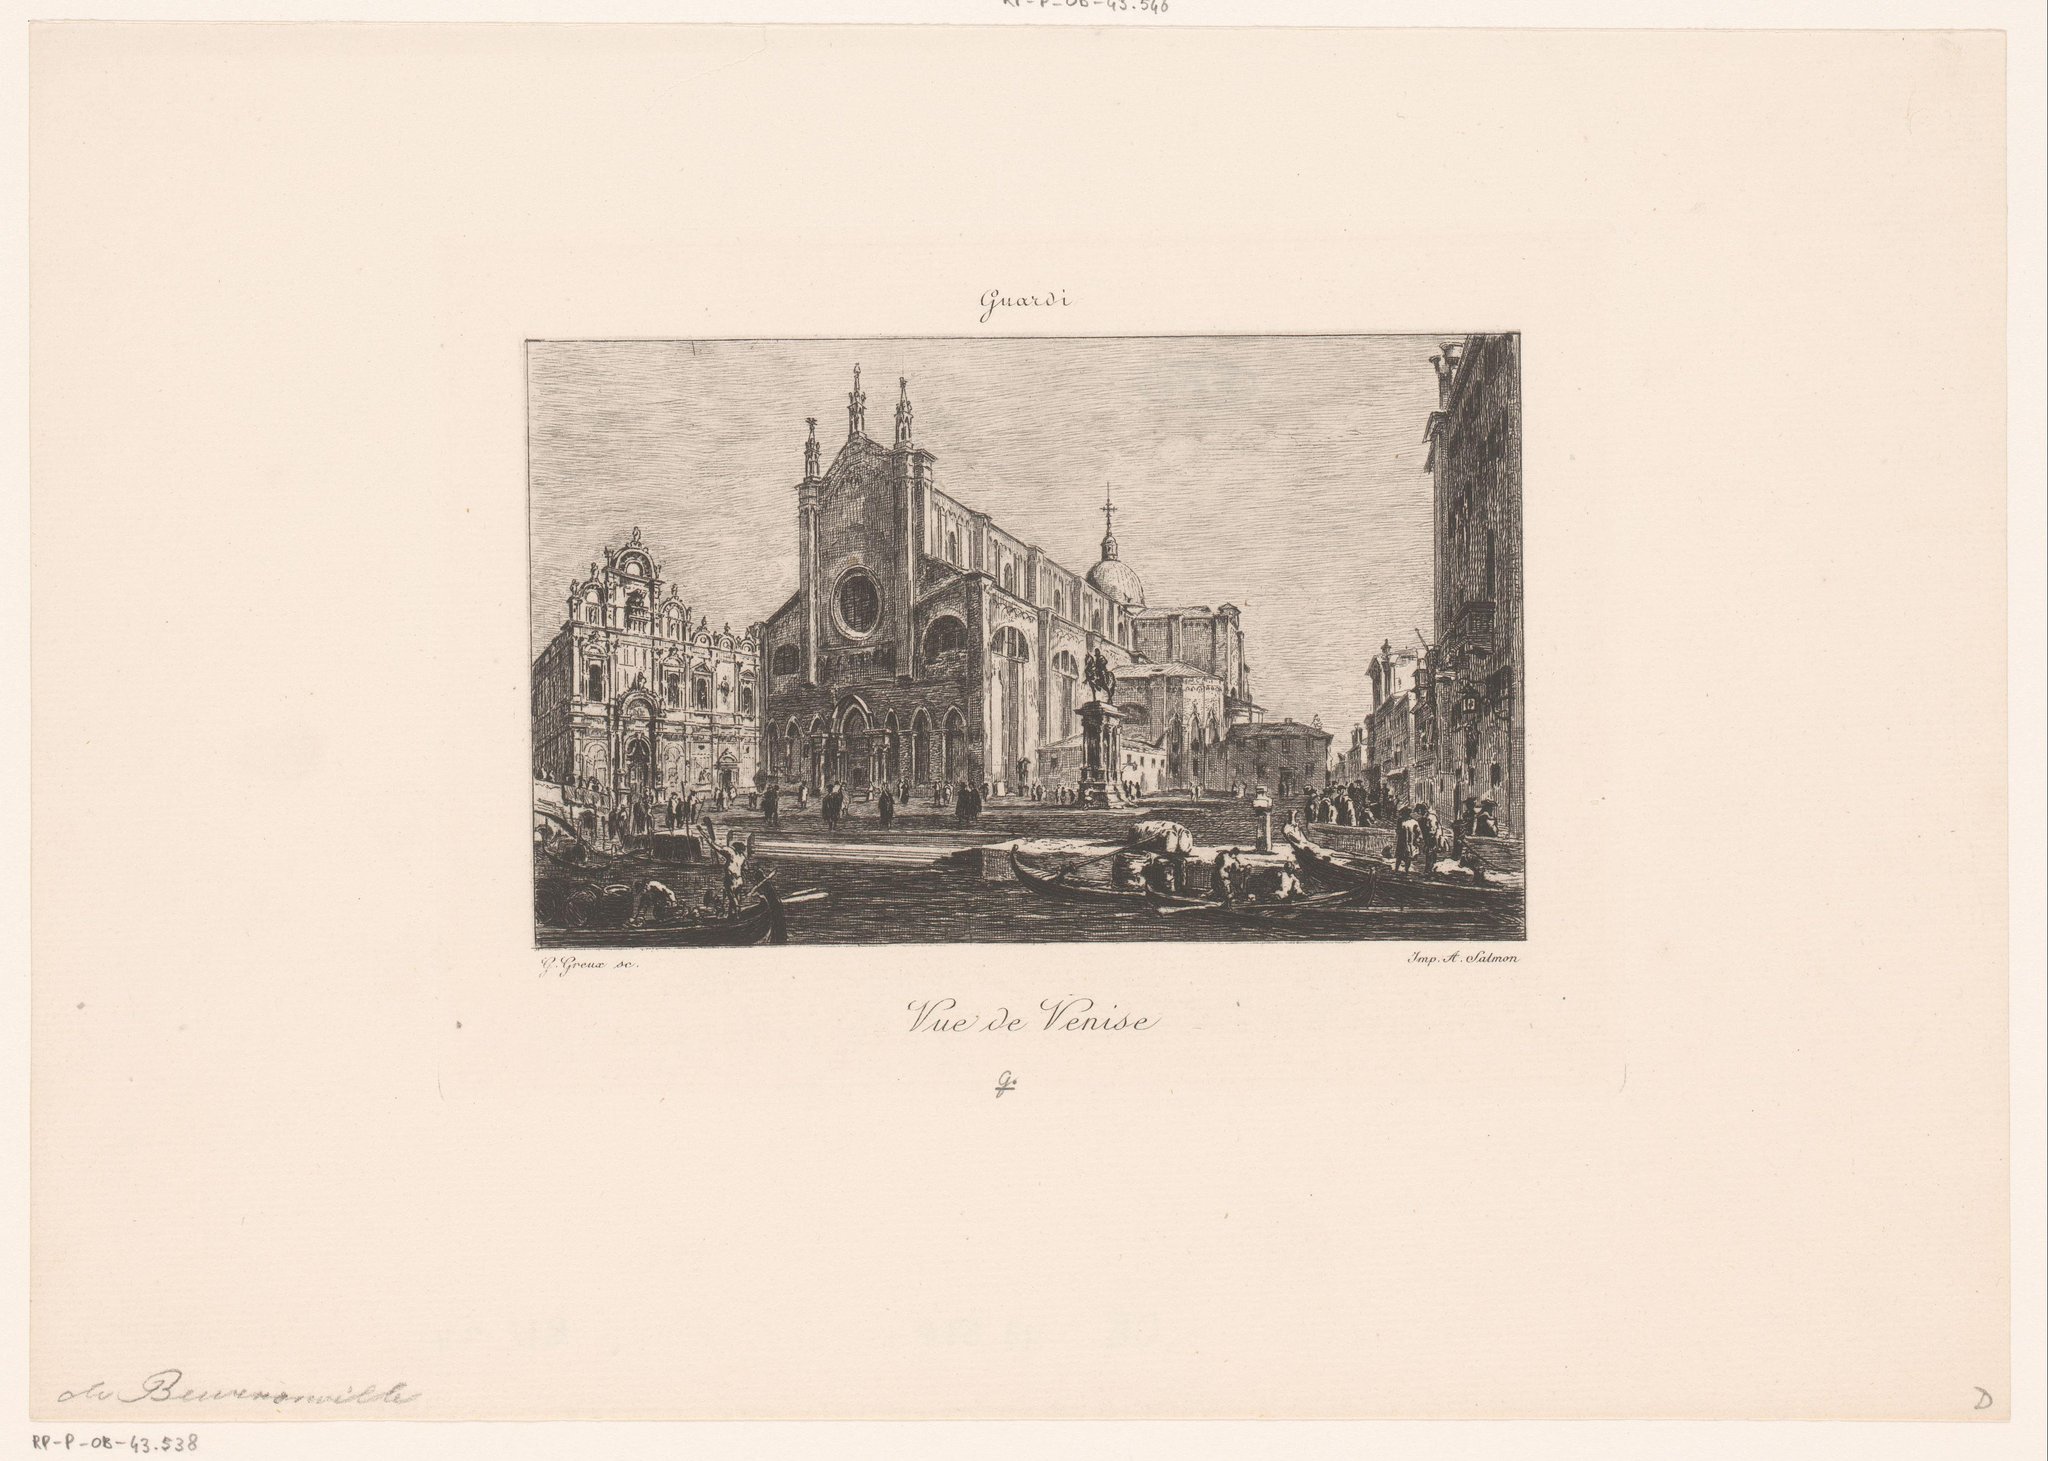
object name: print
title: Vue de Venise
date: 1881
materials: paper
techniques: etching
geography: paris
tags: city-view in general; 'veduta', church (exterior), venice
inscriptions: collector's mark: Lugt 2228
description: Prent afkomstig uit een veilingcatalogus: "Catalogue des Tableaux anciens composant la très importante collection de Monsieur le Baron de Beurnonville", uitgegeven in 1881 te Parijs door Pillet en Dumoulin. De veiling vond plaats op 9 tot en met 14 en 16 mei 1881.